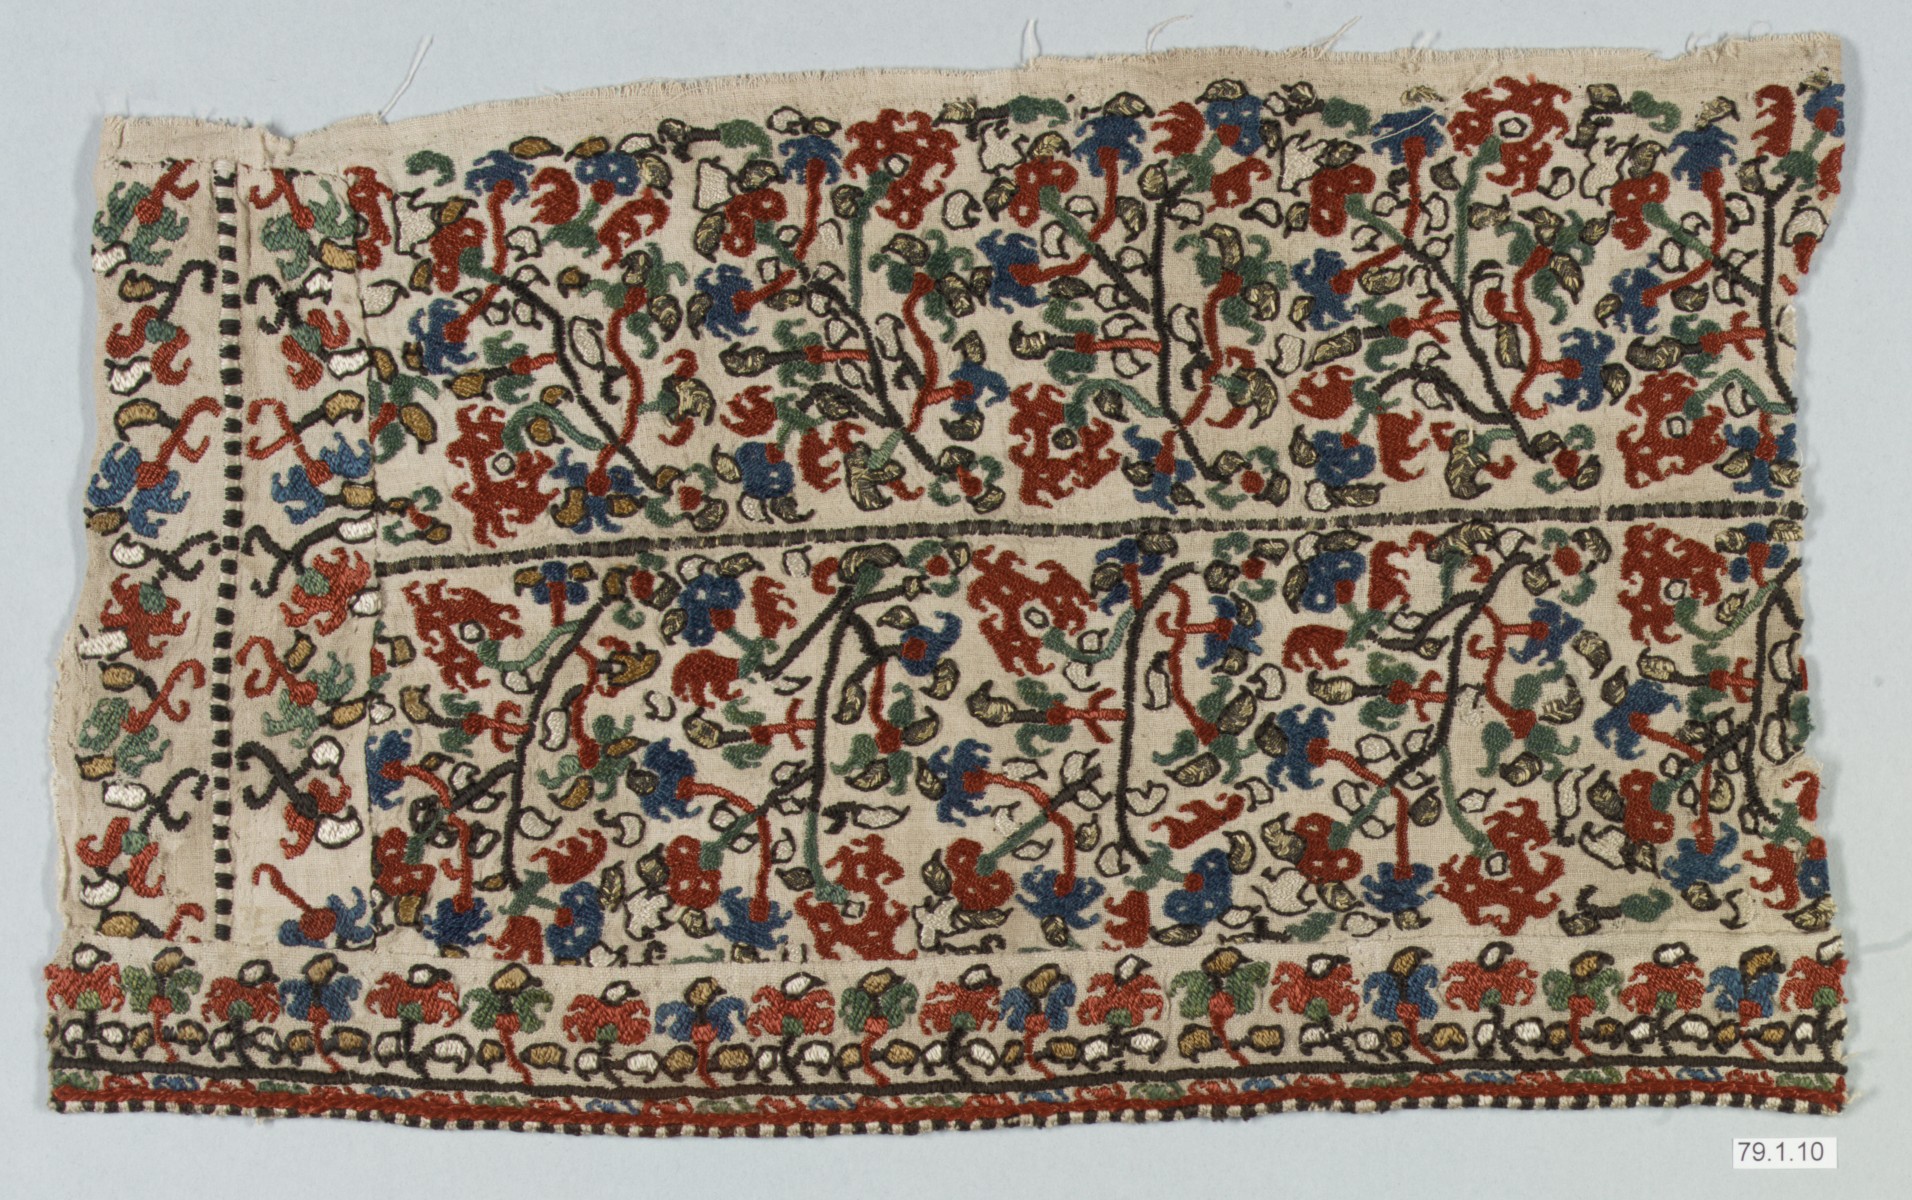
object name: joined fragment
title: Joined Fragments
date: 1801-1833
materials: linen, metal thread, silk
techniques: embroidery, weave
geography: greece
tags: flowers